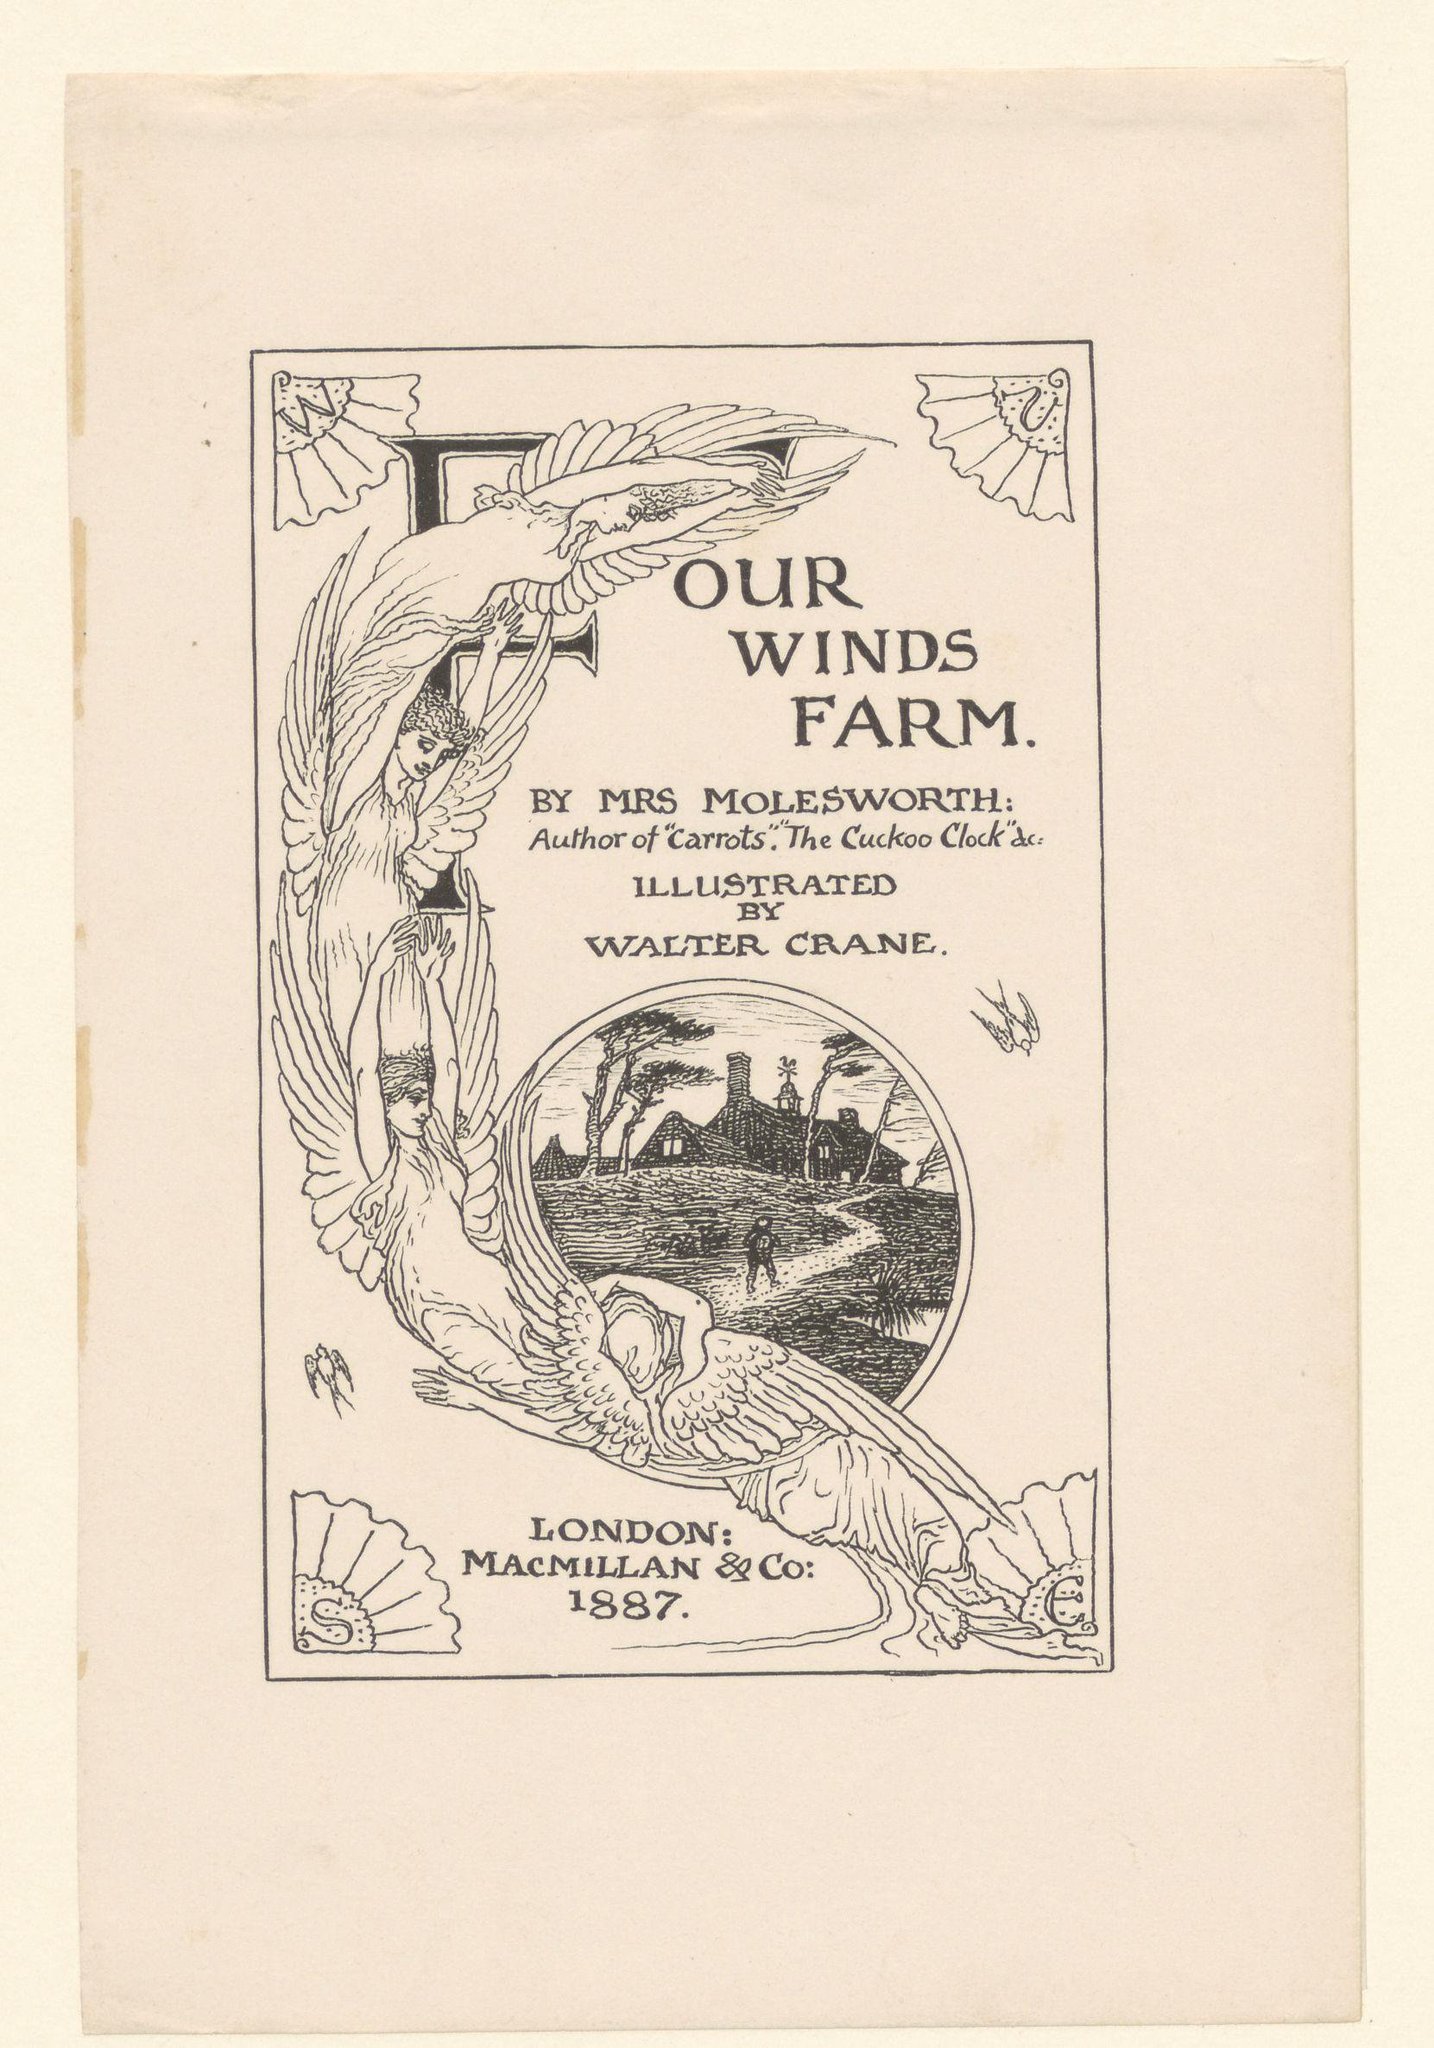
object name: print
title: Titelpagina voor: Molesworth, Four winds farm, 1887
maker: walter crane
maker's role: draughtsman, print maker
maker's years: 1845-1915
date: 1887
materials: paper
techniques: engraving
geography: london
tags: fabulous beings with wings - aa - female human figure, road, path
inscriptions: collector's mark: Lugt 2228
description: Titelpagina voor: Molesworth. Four winds farm. Londen: MacMillan & Co., 1887.